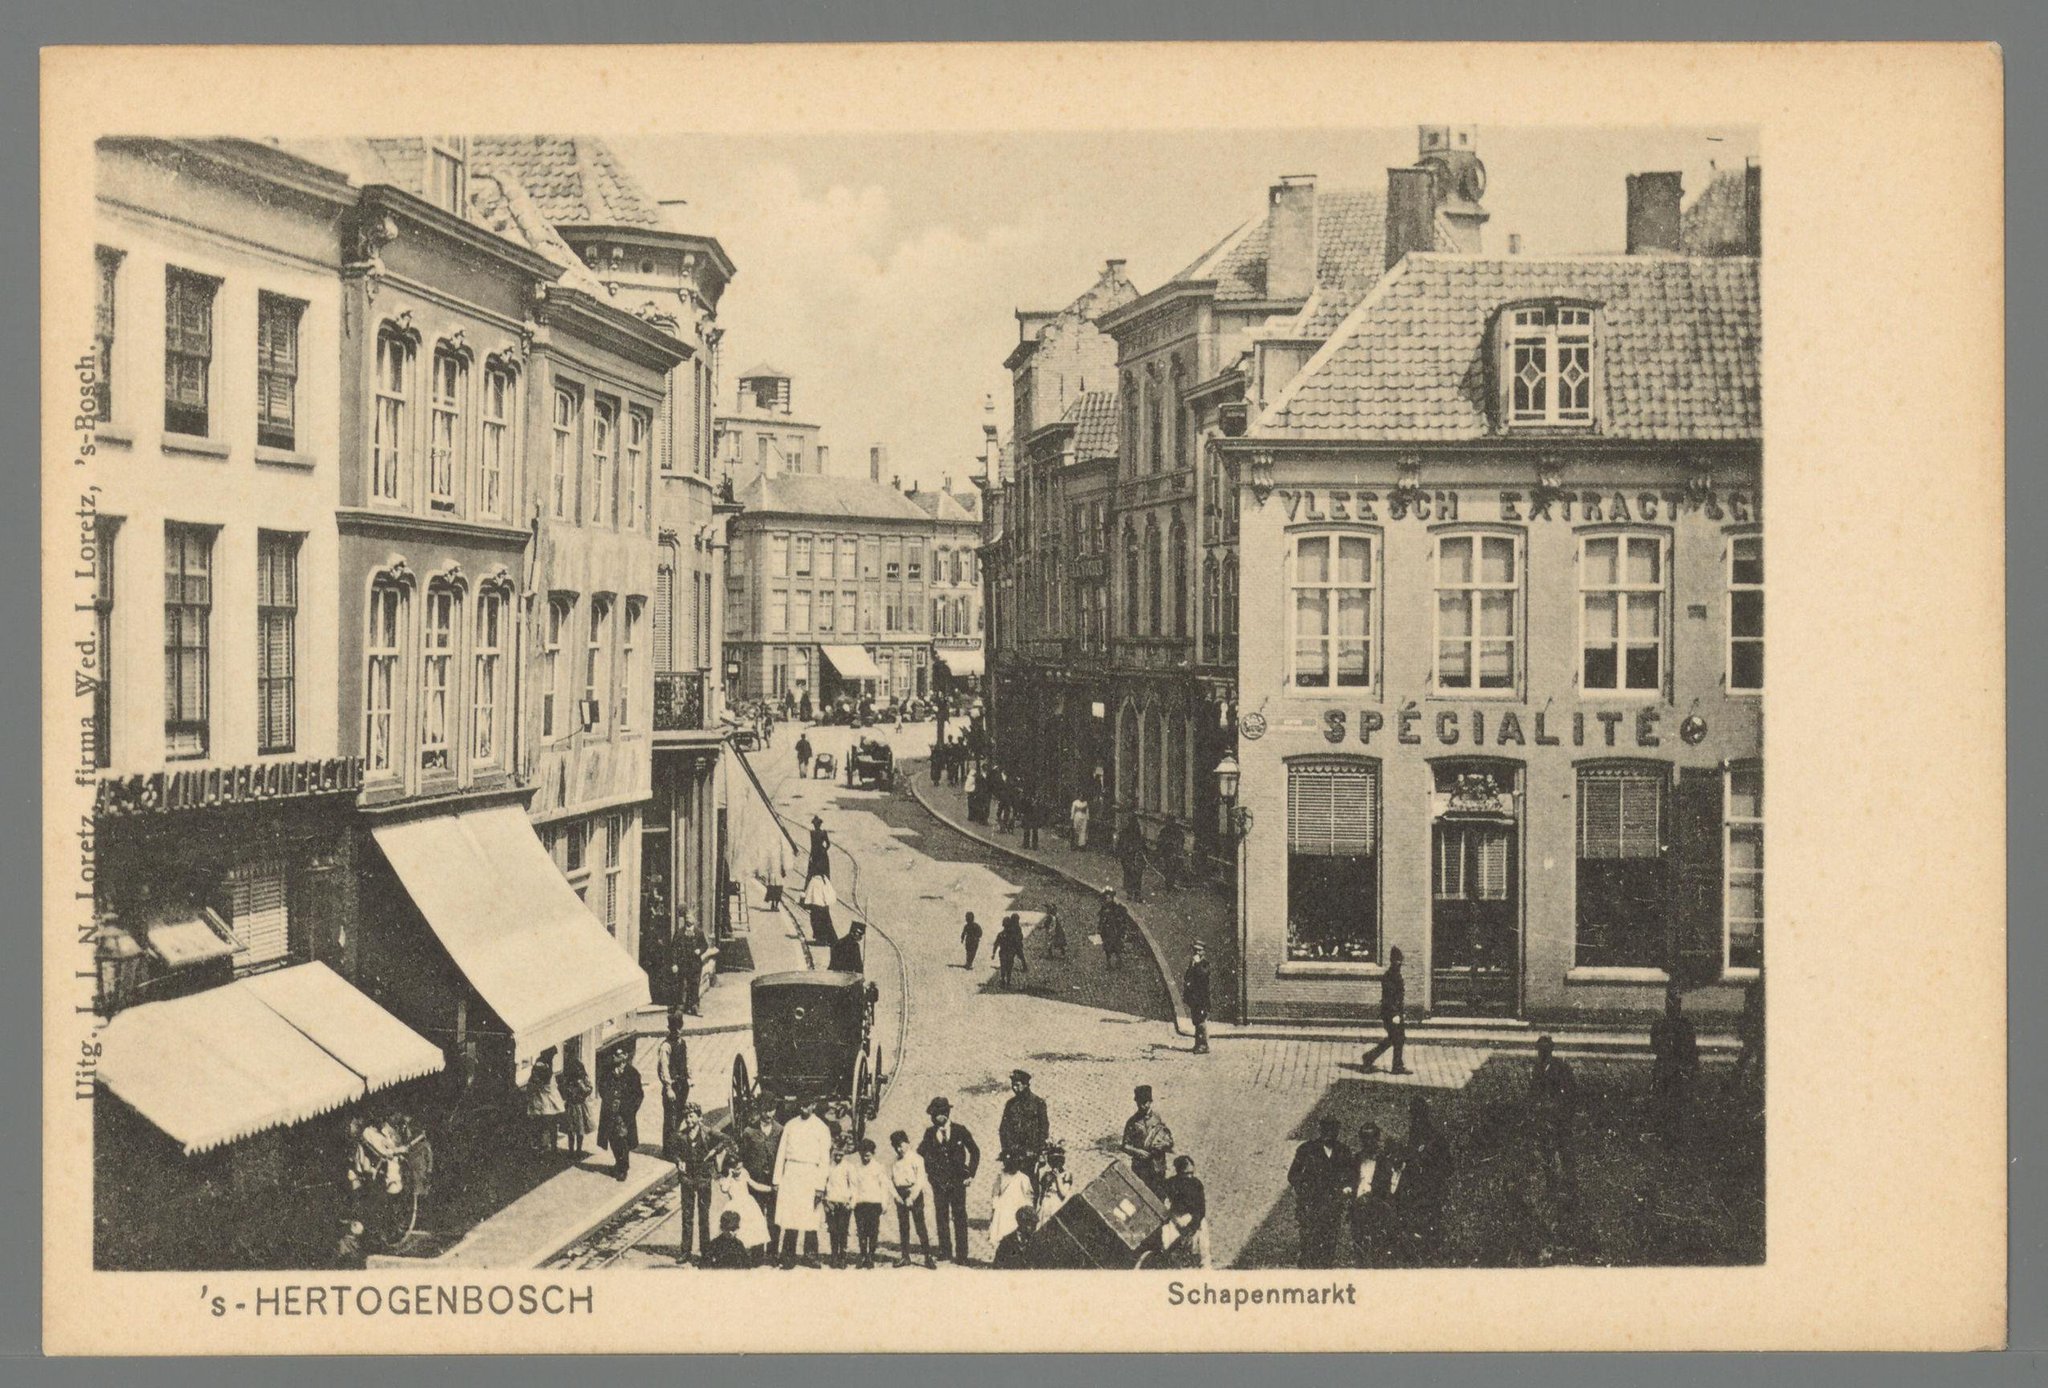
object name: ansichtkaart, prentbriefkaart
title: 's-Hertogenbosch. Schapenmarkt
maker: Anonymous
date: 1900-1905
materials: cardboard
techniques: photograph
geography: den bosch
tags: street, den bosch